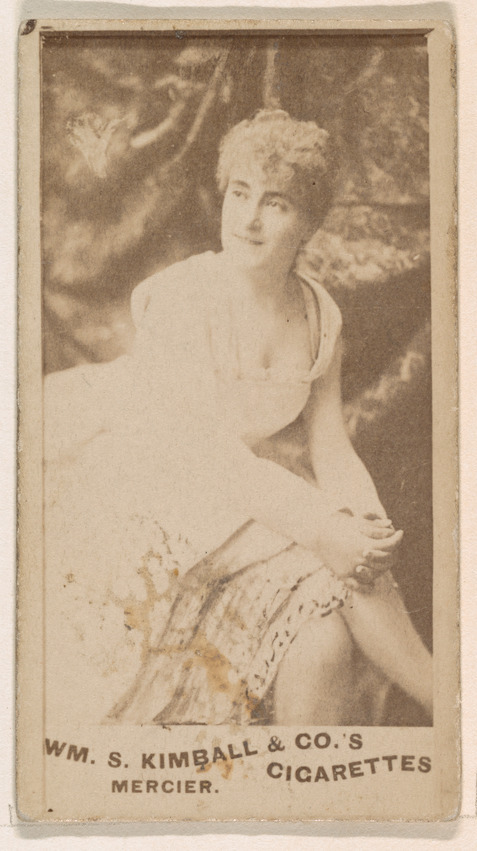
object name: photograph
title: Miss Mercier, from the Actresses series (N203) issued by Wm. S. Kimball & Co.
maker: william s. kimball & company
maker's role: publisher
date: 1889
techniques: color lithograph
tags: portraits,women,actresses